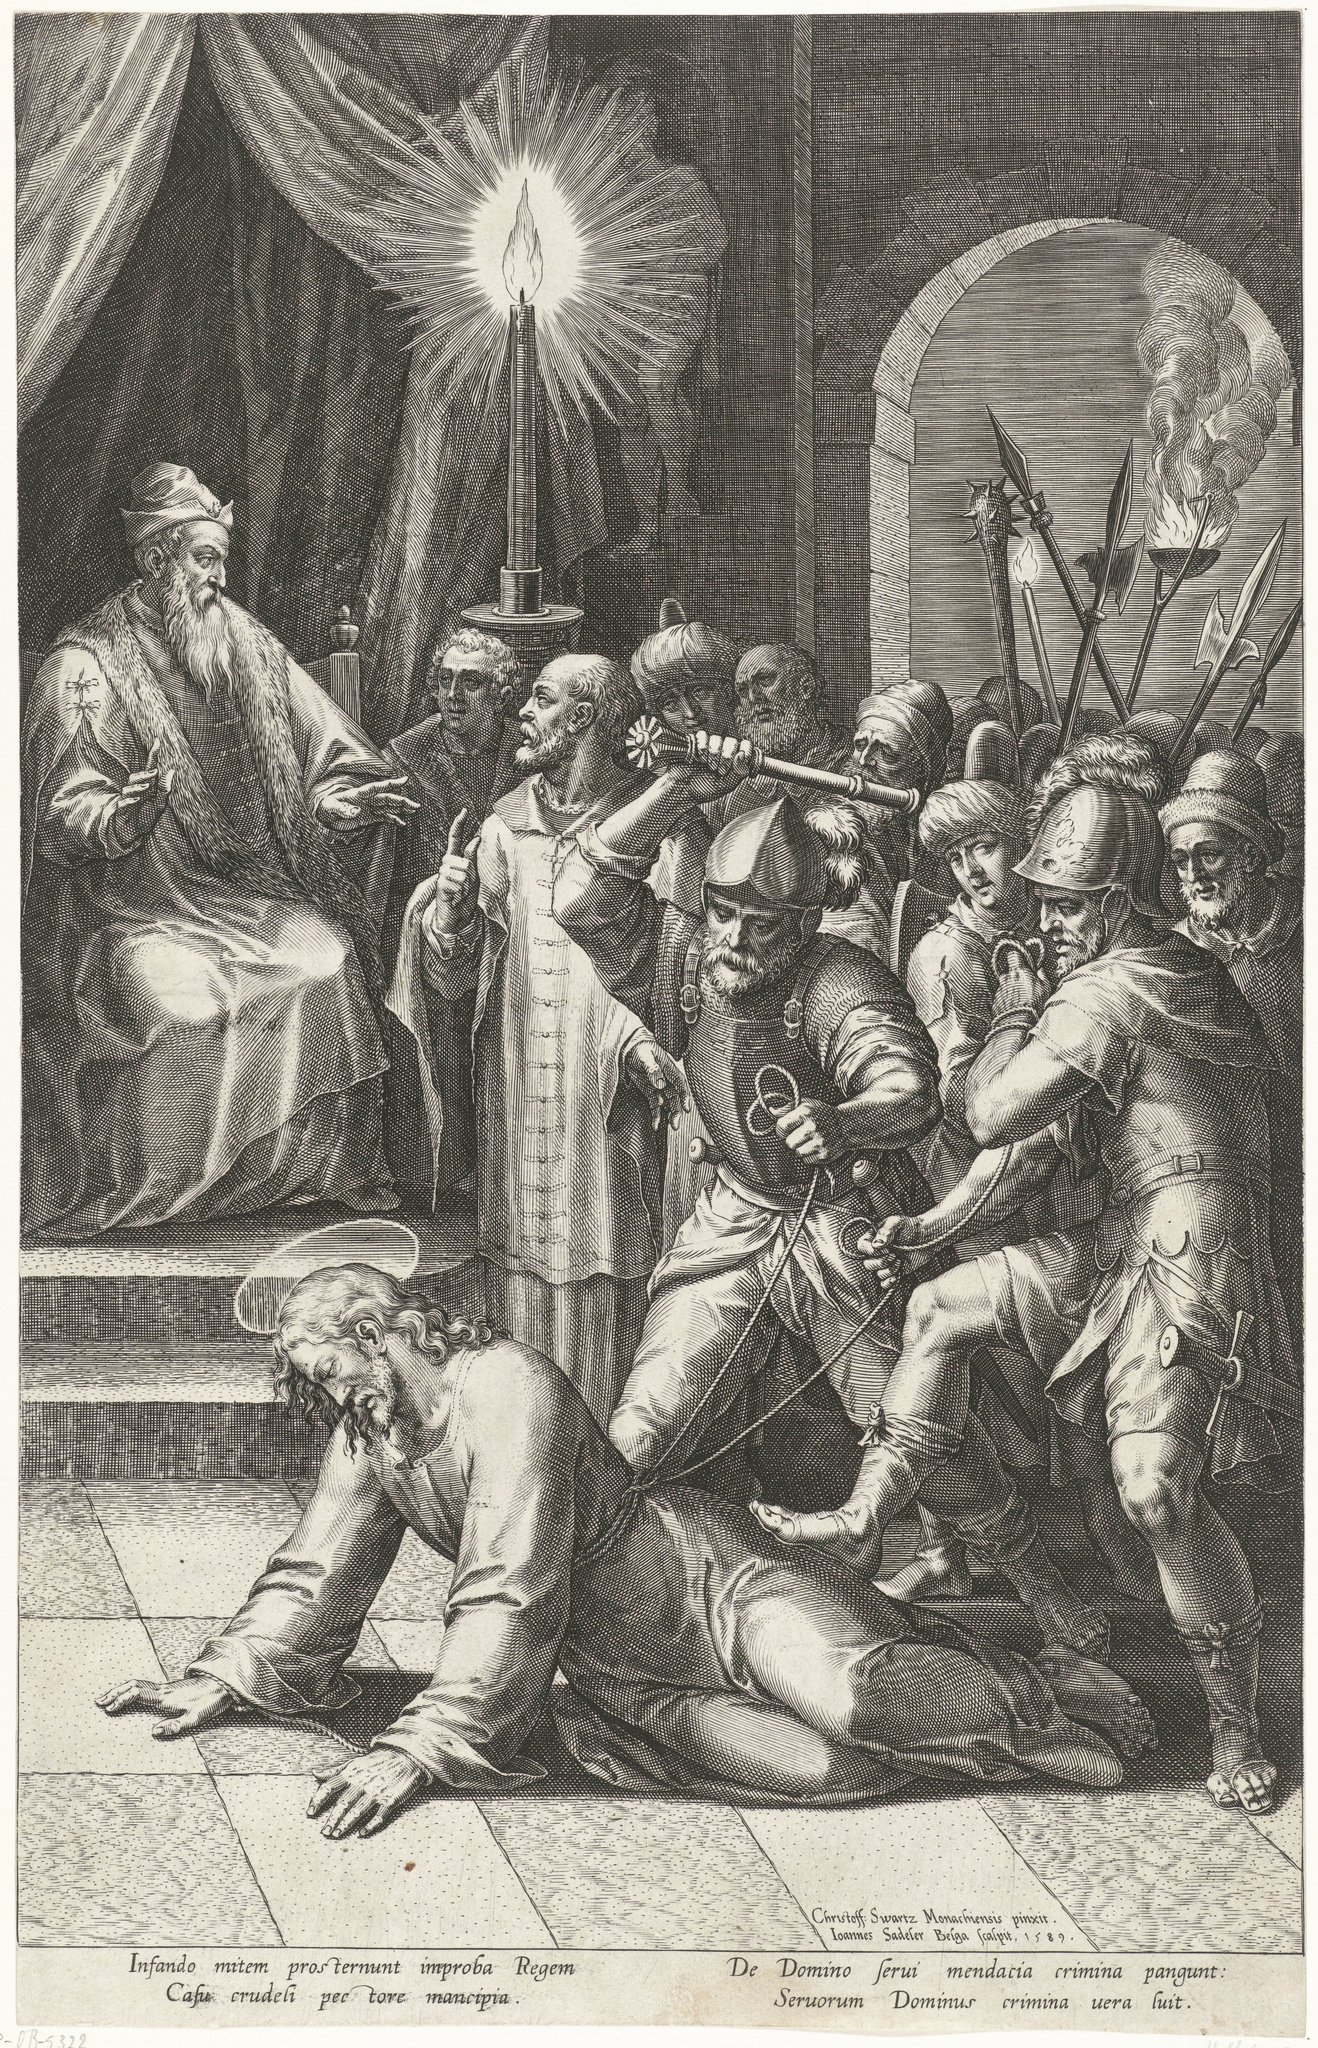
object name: print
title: Christus voor het Sanhedrin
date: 1589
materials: paper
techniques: engraving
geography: munich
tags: false witnesses ~ trial of christ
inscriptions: collector's mark: Lugt 240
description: Christus voor het Sanhedrin. Hij ligt op de grond voor de troon van hogepriester Kajafas en is vastgebonden met een touw dat wordt vastgehouden door twee soldaten. Naast de troon legt een man een valse getuigenis af over de daden van Christus. Een van de soldaten slaat Christus met een stok omdat hij blijft zwijgen. De eerste prent van een achtdelige serie over de passie van Christus.